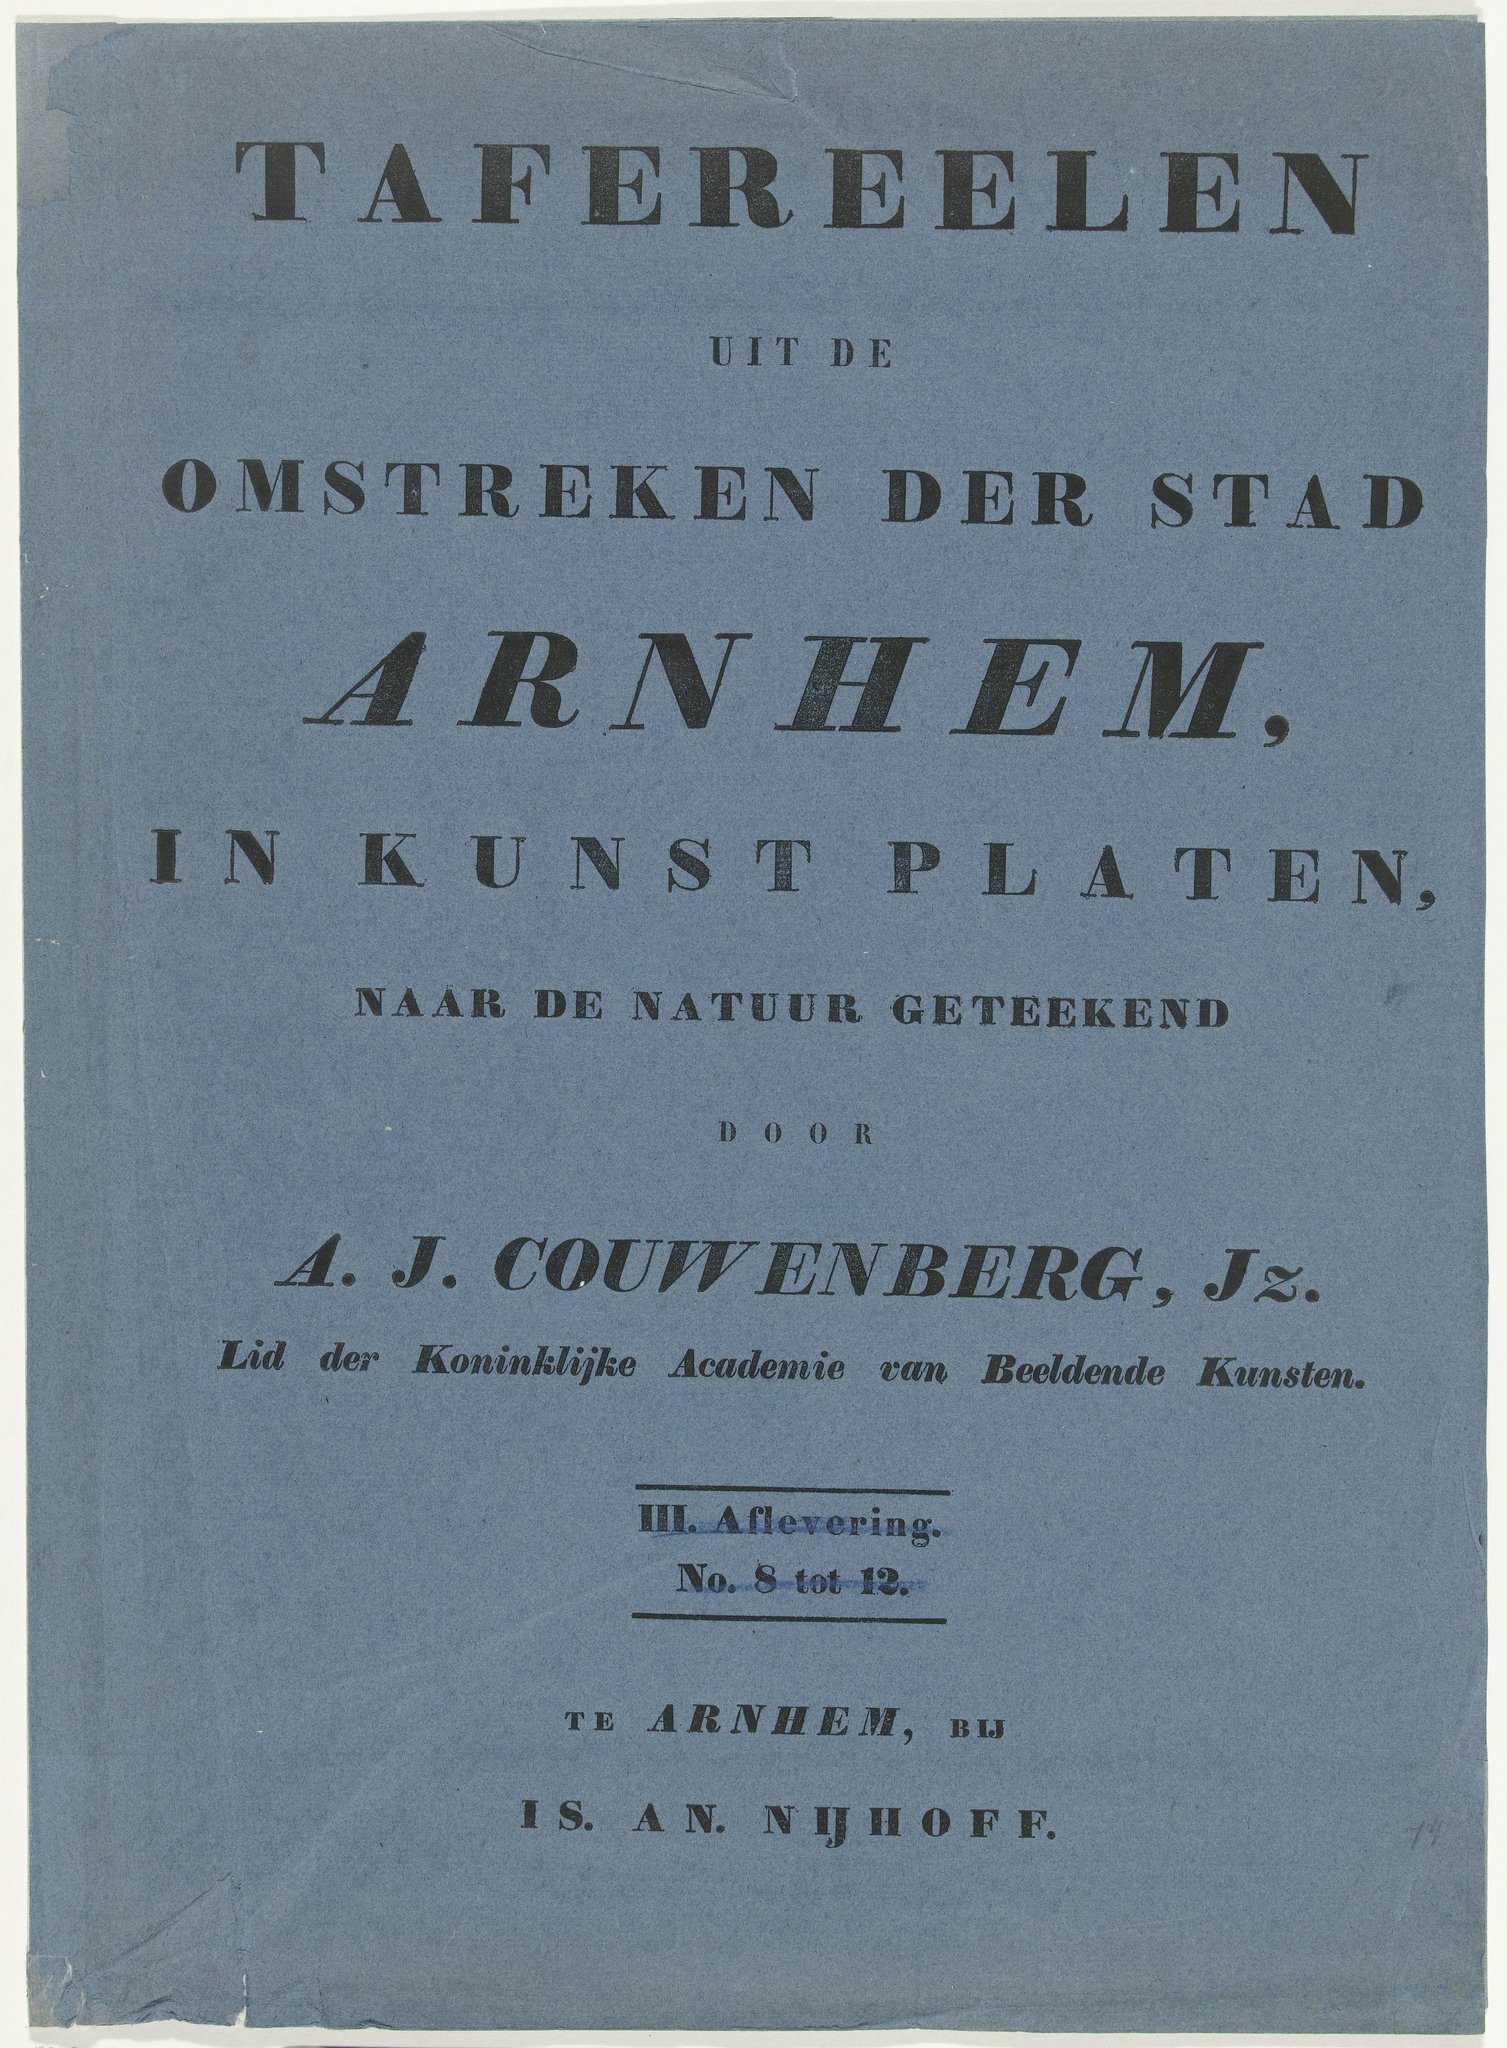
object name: wrapper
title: Omslag voor de prentenserie: Tafereelen uit de omstreken der stad Arnhem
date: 1838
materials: paper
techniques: letterpress printing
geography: arnhem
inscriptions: collector's mark: Lugt 2228